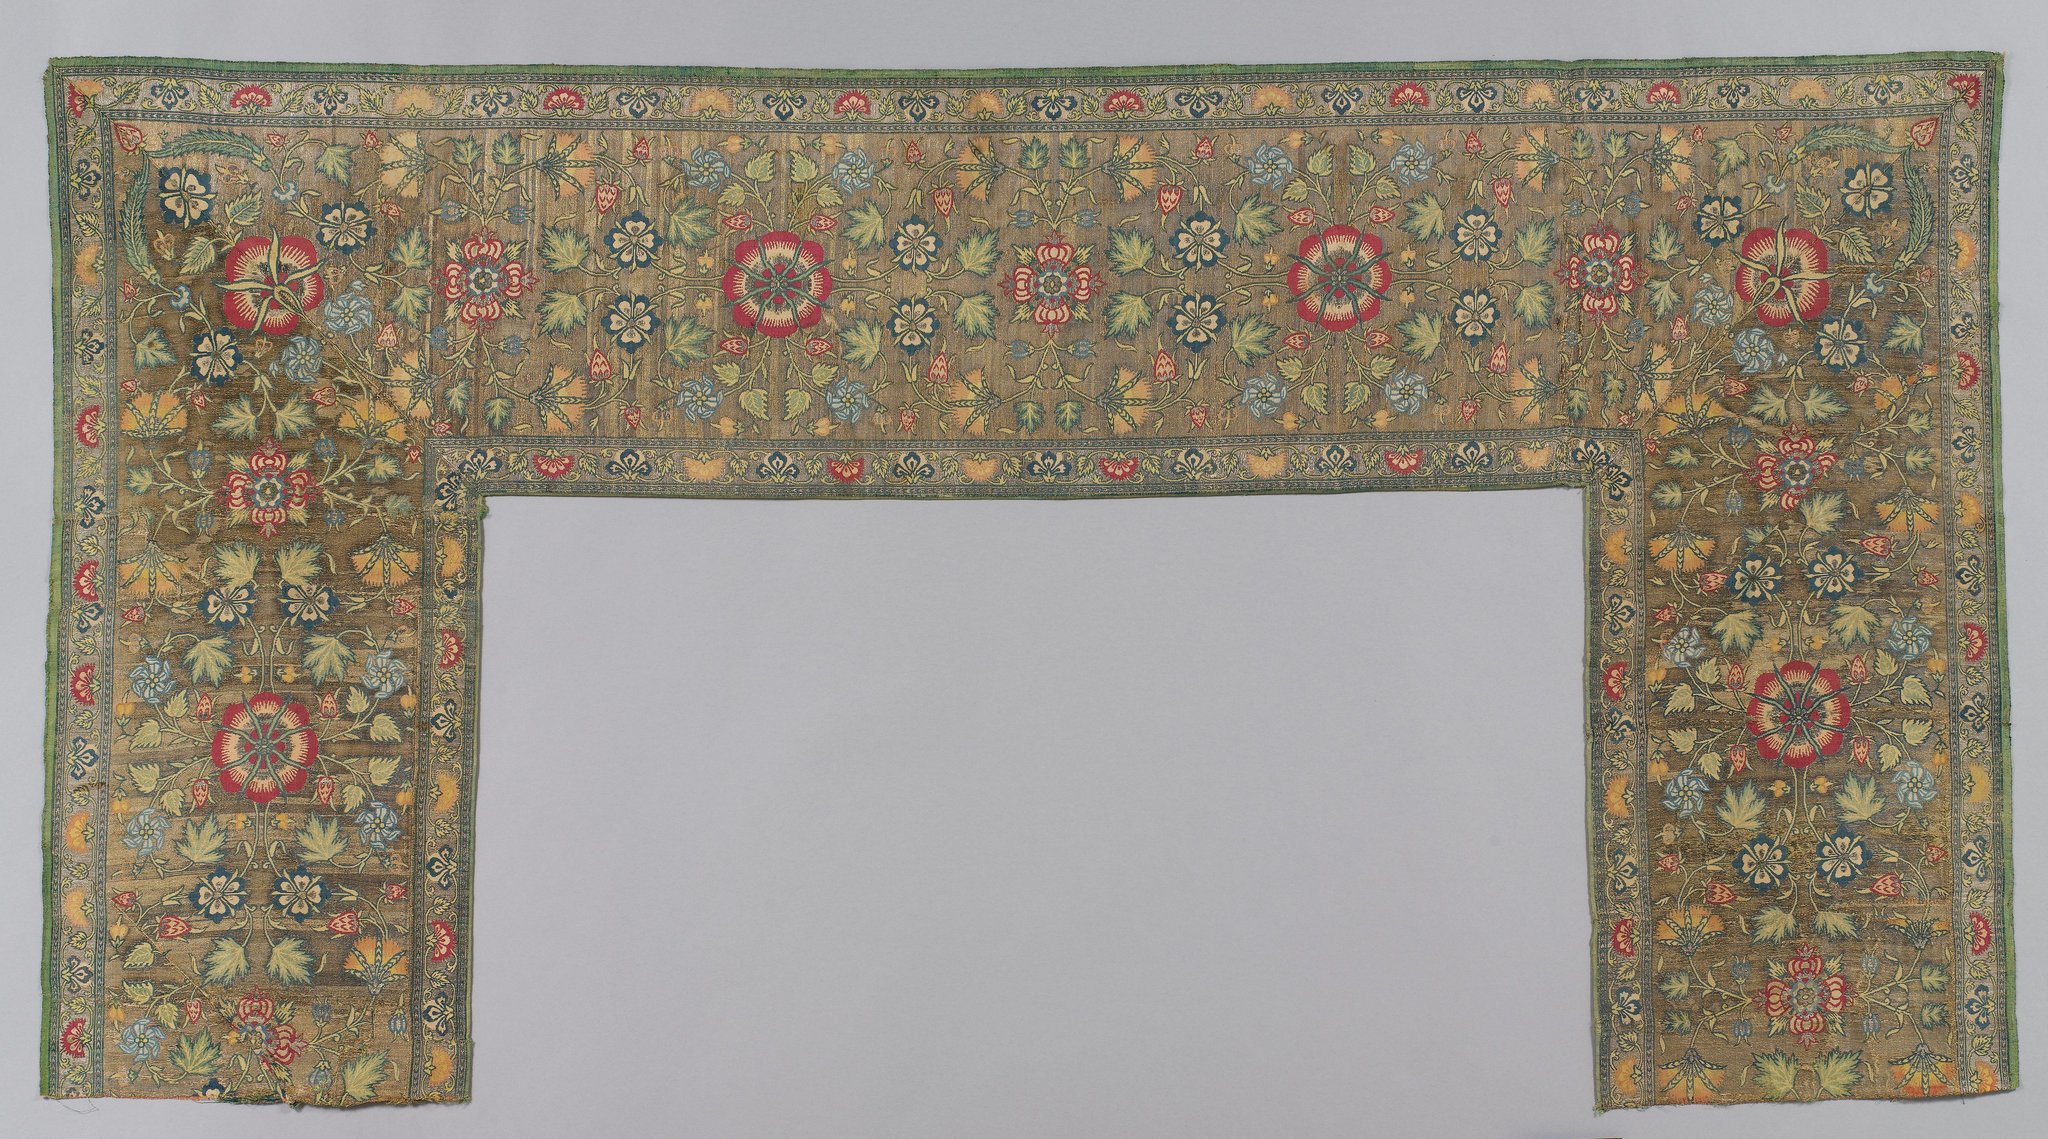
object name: fragment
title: Border of a Luxurious Floor Covering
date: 1600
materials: gold, silk, silver, thread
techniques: lampas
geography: iran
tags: flowers